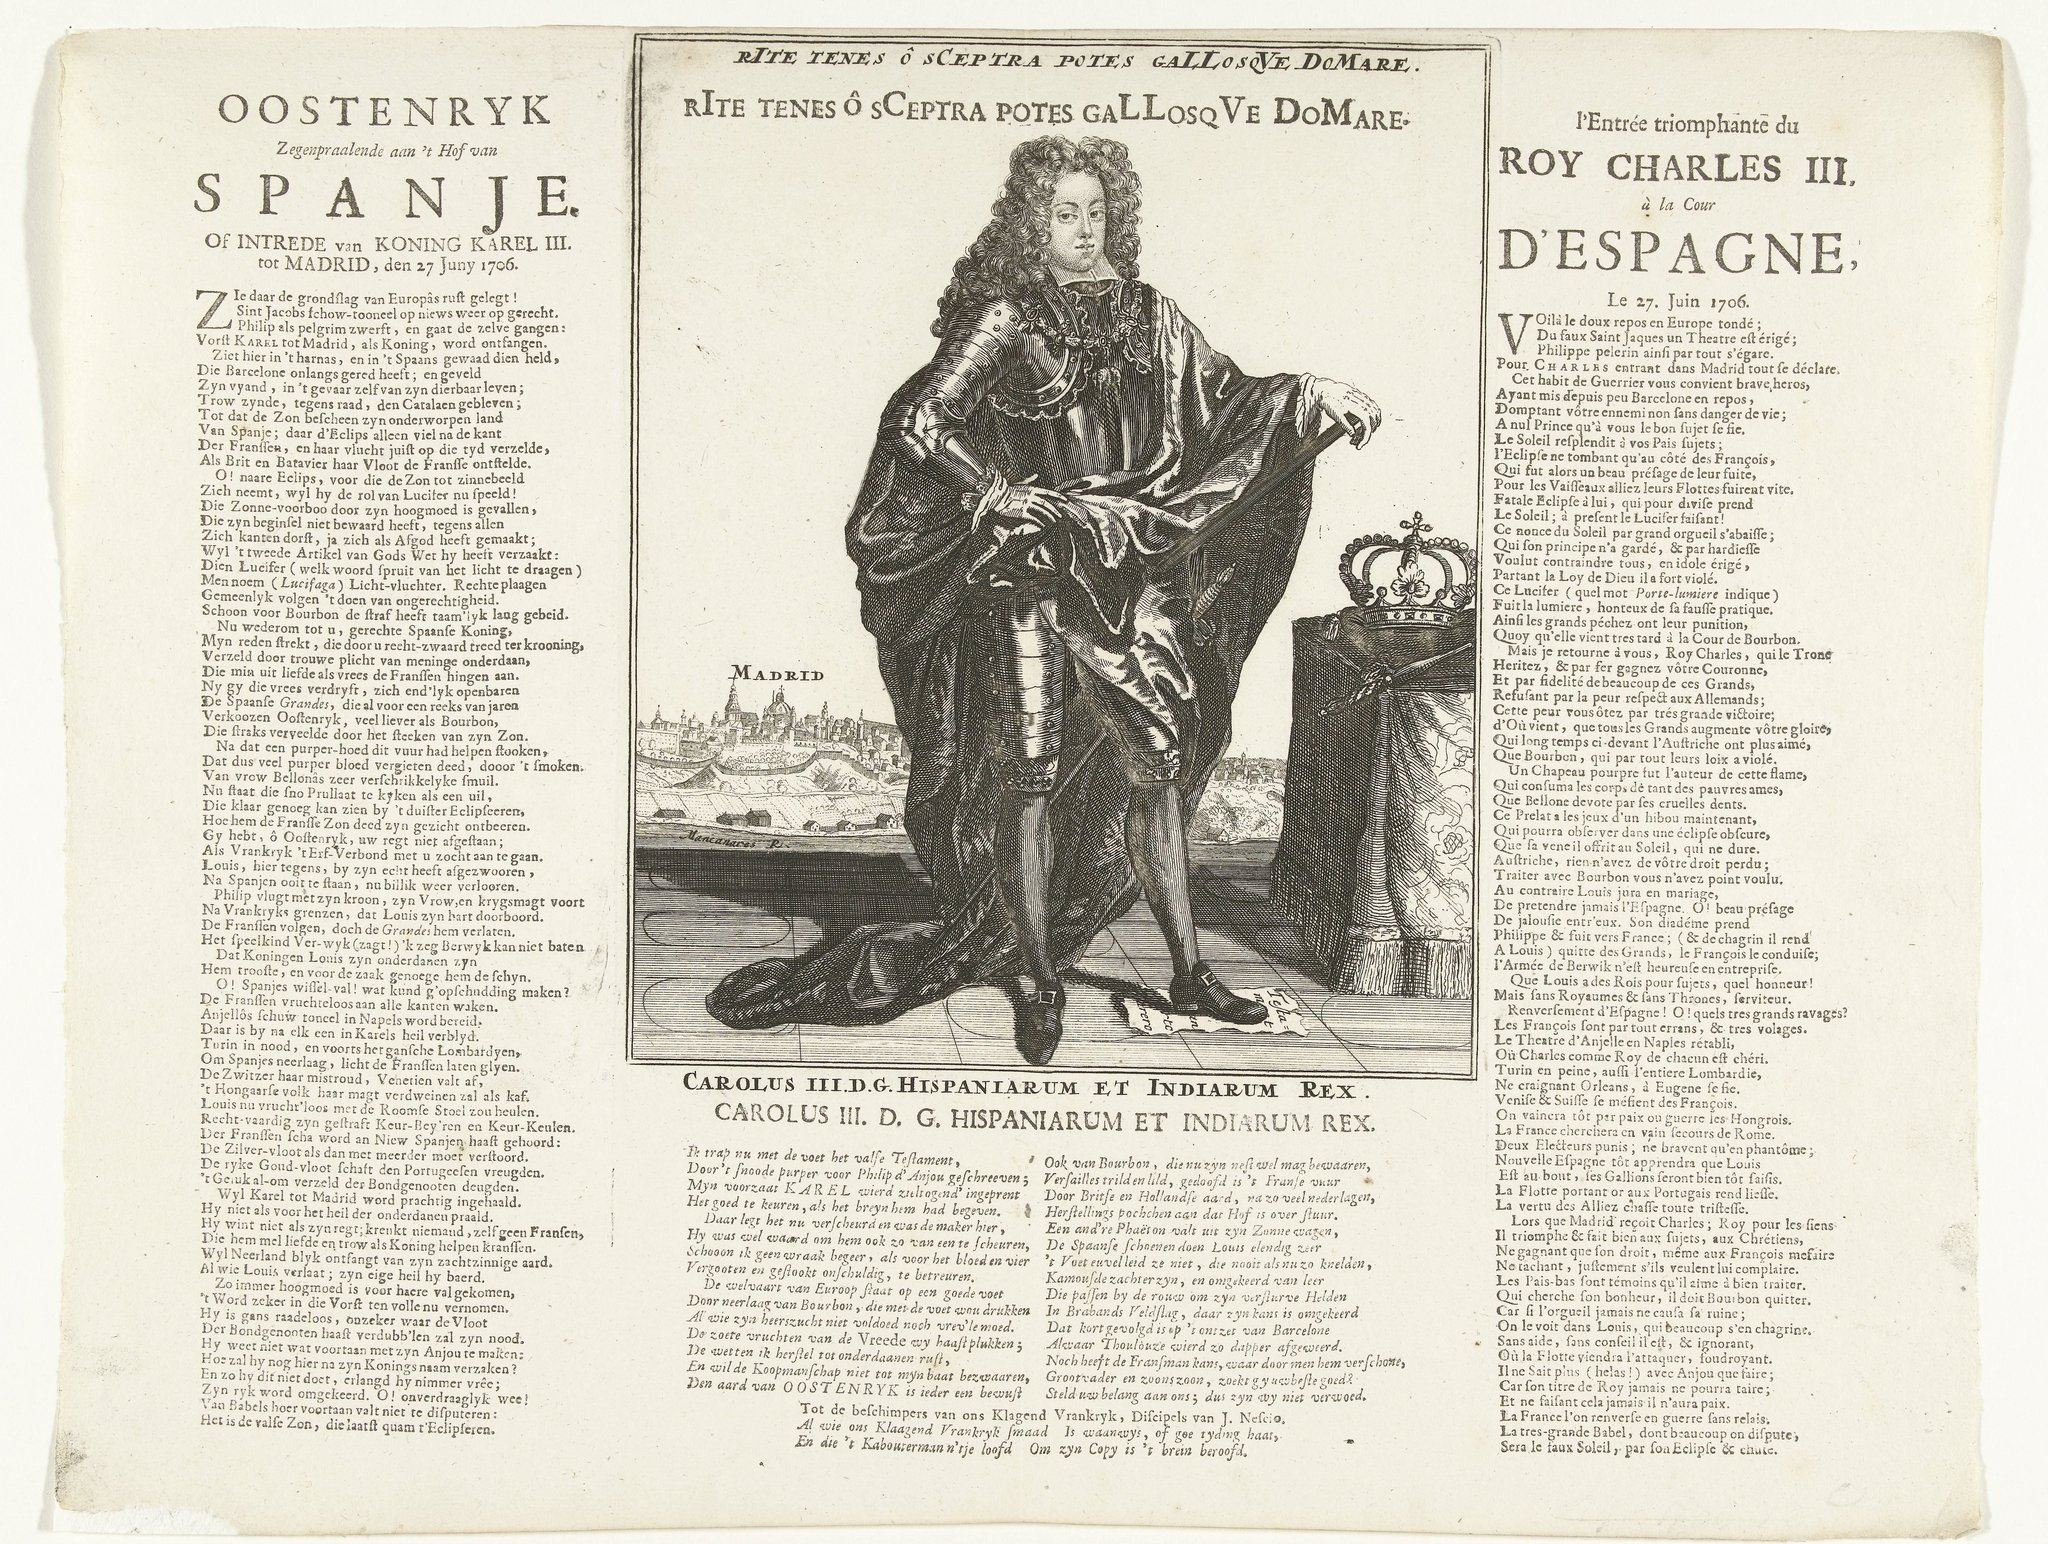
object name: print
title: Oostenryk Zegenpraalende aan 't Hof van Spanje. Of Intrede van Koning Karel III. tot Madrid, den 27 Juny 1706 / l'Entrée triomphante du Roy Charles III. à la Cour D'Espagne, Le 27. Juin 1706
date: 1706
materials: paper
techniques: etching, letterpress printing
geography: northern netherlands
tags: vienna, charles vi (holy roman emperor)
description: Aartshertog Karel van Oostenrijk als Karel III, koning van Spanje, staande ten voeten uit in wapenrusting met mantel en commandostaf, 1706. Op de achtergrond Madrid waar de koning op 27 juni intocht hield. Met verzen in het Nederlands en Frans op het blad aan weerszijden van en onder de plaat. Onderdeel van een reeks van 19 spotprenten op de Fransen en bondgenoten uit het jaar 1706.